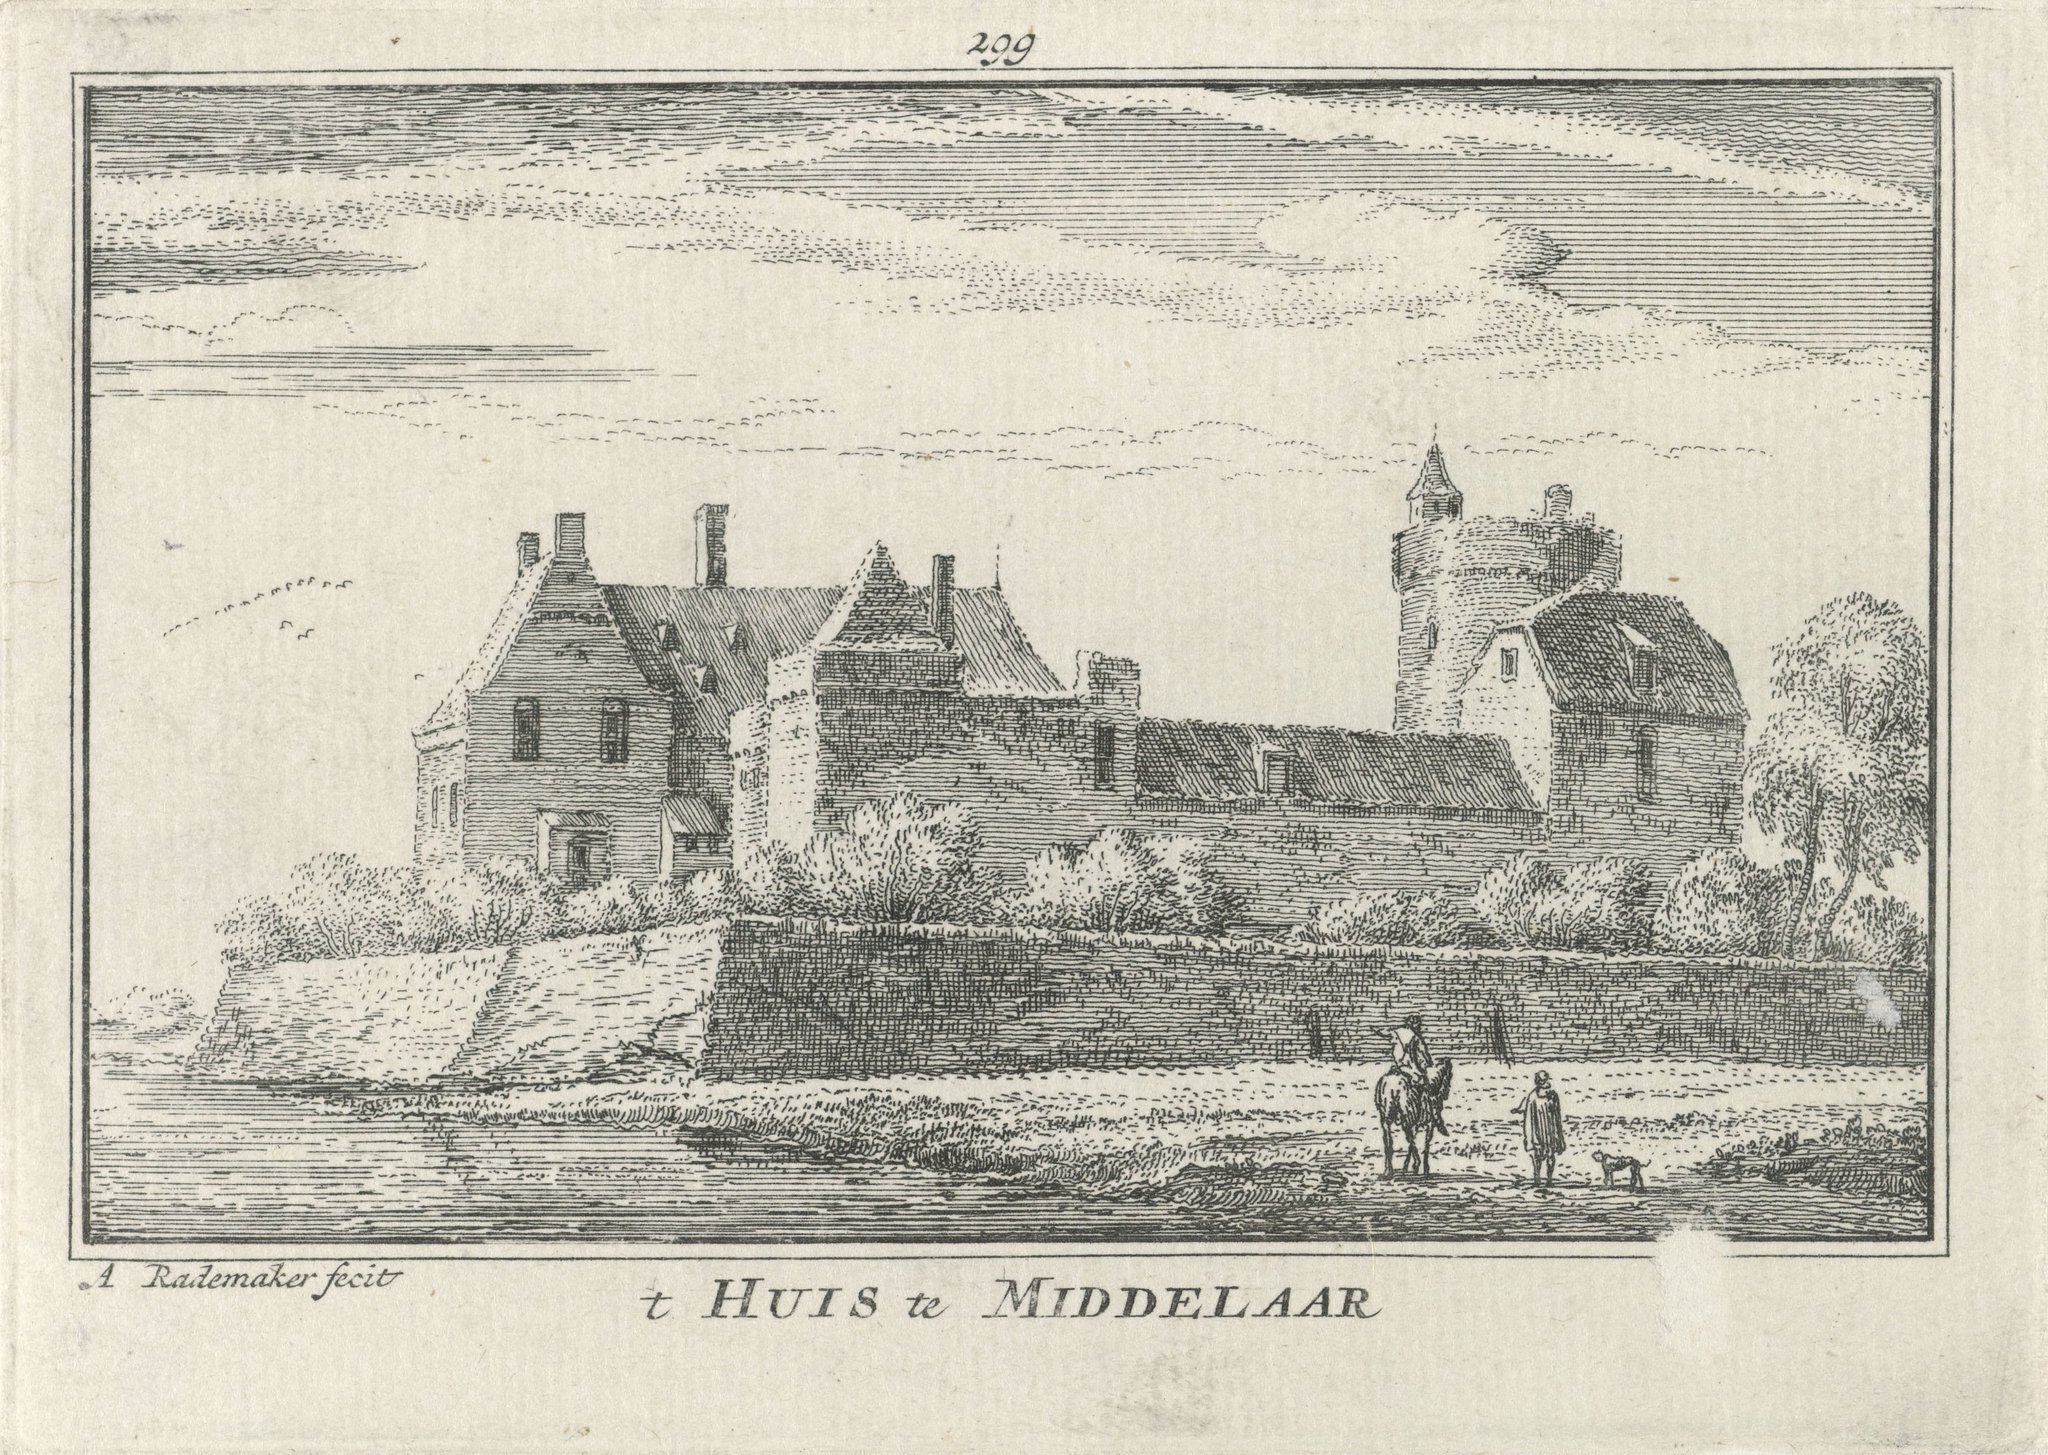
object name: book illustration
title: Kasteel Middelaar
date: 1727-1733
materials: paper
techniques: etching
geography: amsterdam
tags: 'en route', traveller under way, dog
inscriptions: collector's mark: Lugt 2228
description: Illustratie uit: Abraham Rademaker, Matthaeus Brouërius van Niedek, Isaac Le Long, Kabinet van Nederlandsche en Kleefsche outheden en (...) voorname stads- en landgebouwen, Willem Barents en Antoni Schoonenburg: Amsterdam, 1727-1733, ill. nr. 299.